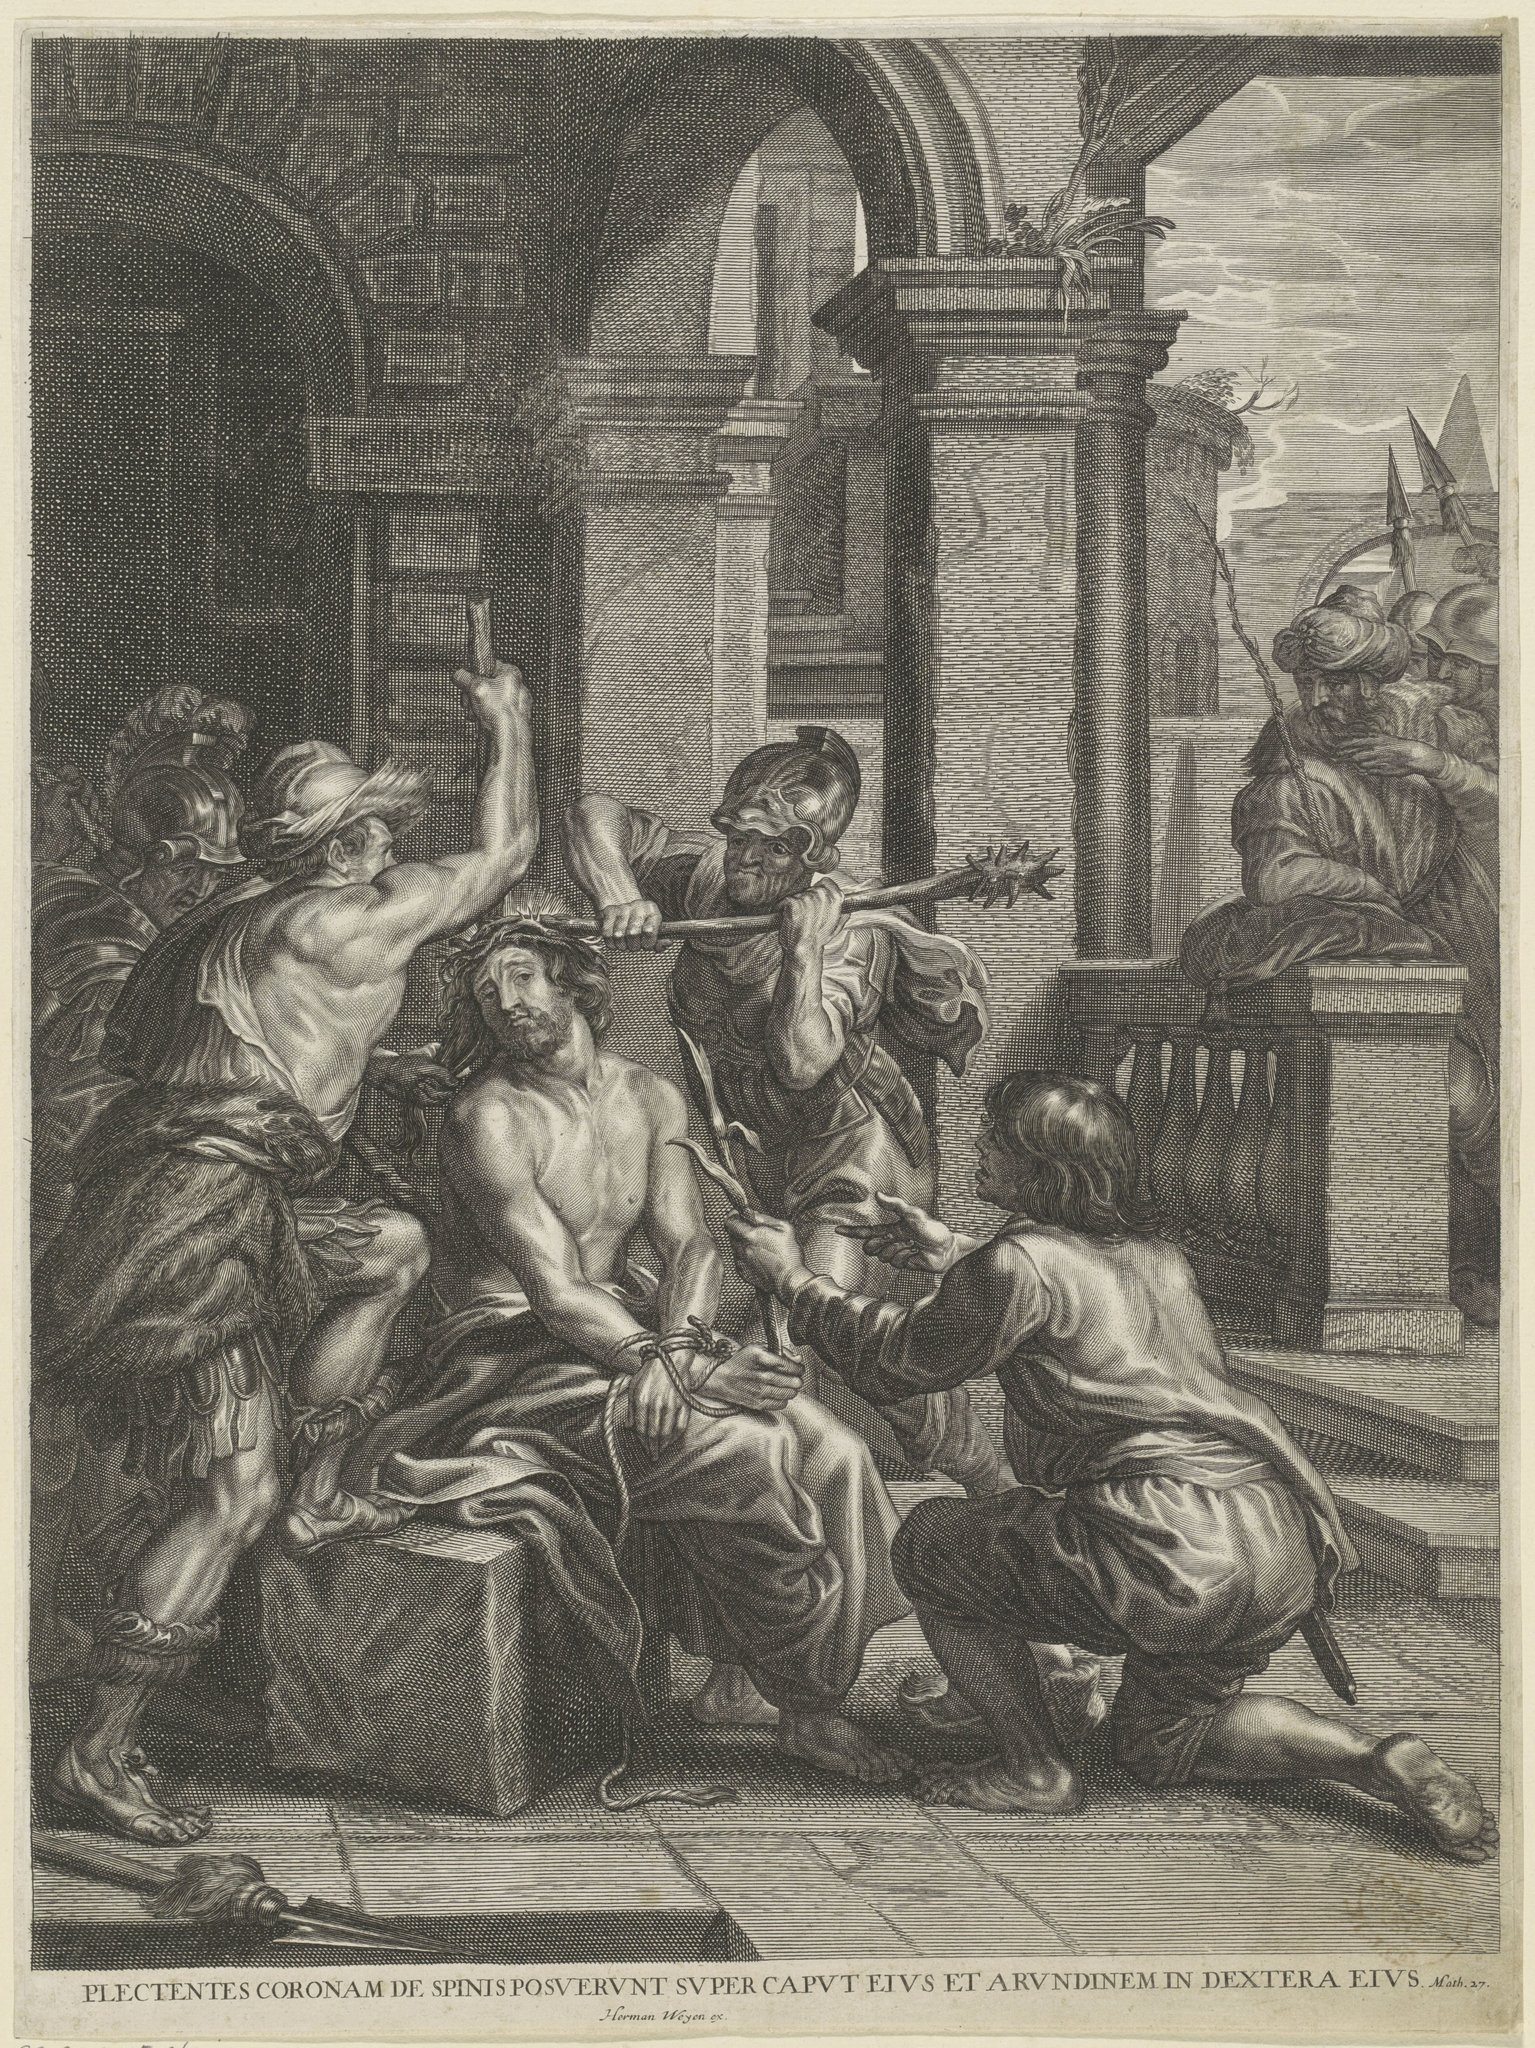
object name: print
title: Plectentes coronam de spinis posperunt super caput eius et arundinem in dextera eius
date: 1623-1672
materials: paper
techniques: engraving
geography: paris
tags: the crowning with thorns: soldiers with sticks place a thorny crown on christ's head and give him a reed (matthew 27:27-31; mark 15:16-20; john 19:2-3)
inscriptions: collector's mark: Lugt 240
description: Mannen duwen Christus een doornenkroon op het hoofd. Een man knielt voor hem en geeft hem een riet als staf. Rechts kijkt een man met een tulband op het hoofd van achter een balustrade toe.